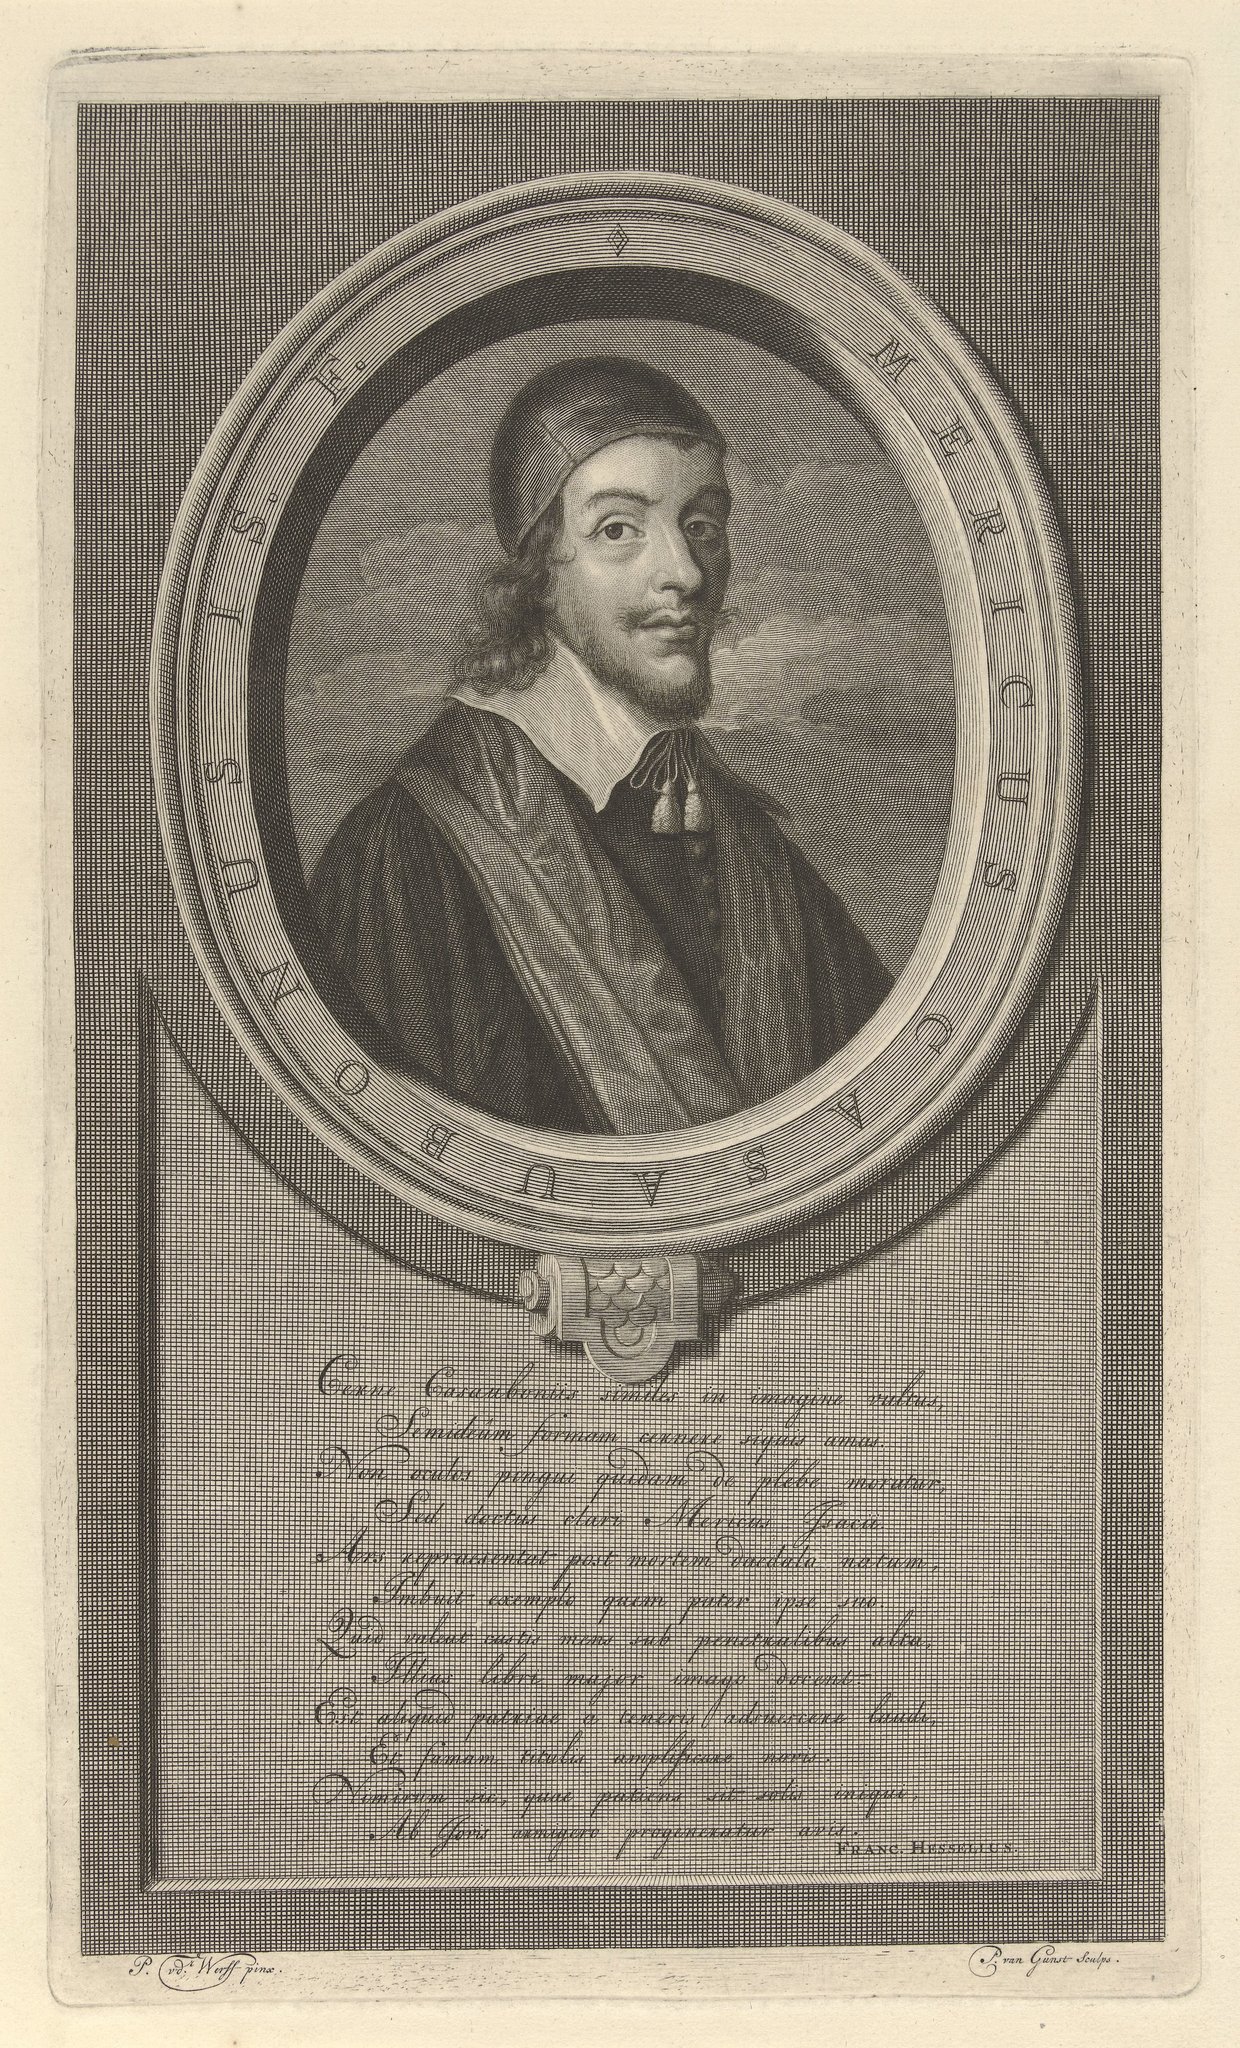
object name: print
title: Portret van Mericus Casaubon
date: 1669-1731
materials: paper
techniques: engraving, etching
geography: amsterdam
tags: theoloog, mericus casaubon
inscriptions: collector's mark: Lugt 240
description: Mericus Casaubon, een Frans-Engelse theoloog en geleerde. De prent heeft als onderschrift een Frans gedicht over zijn leven.